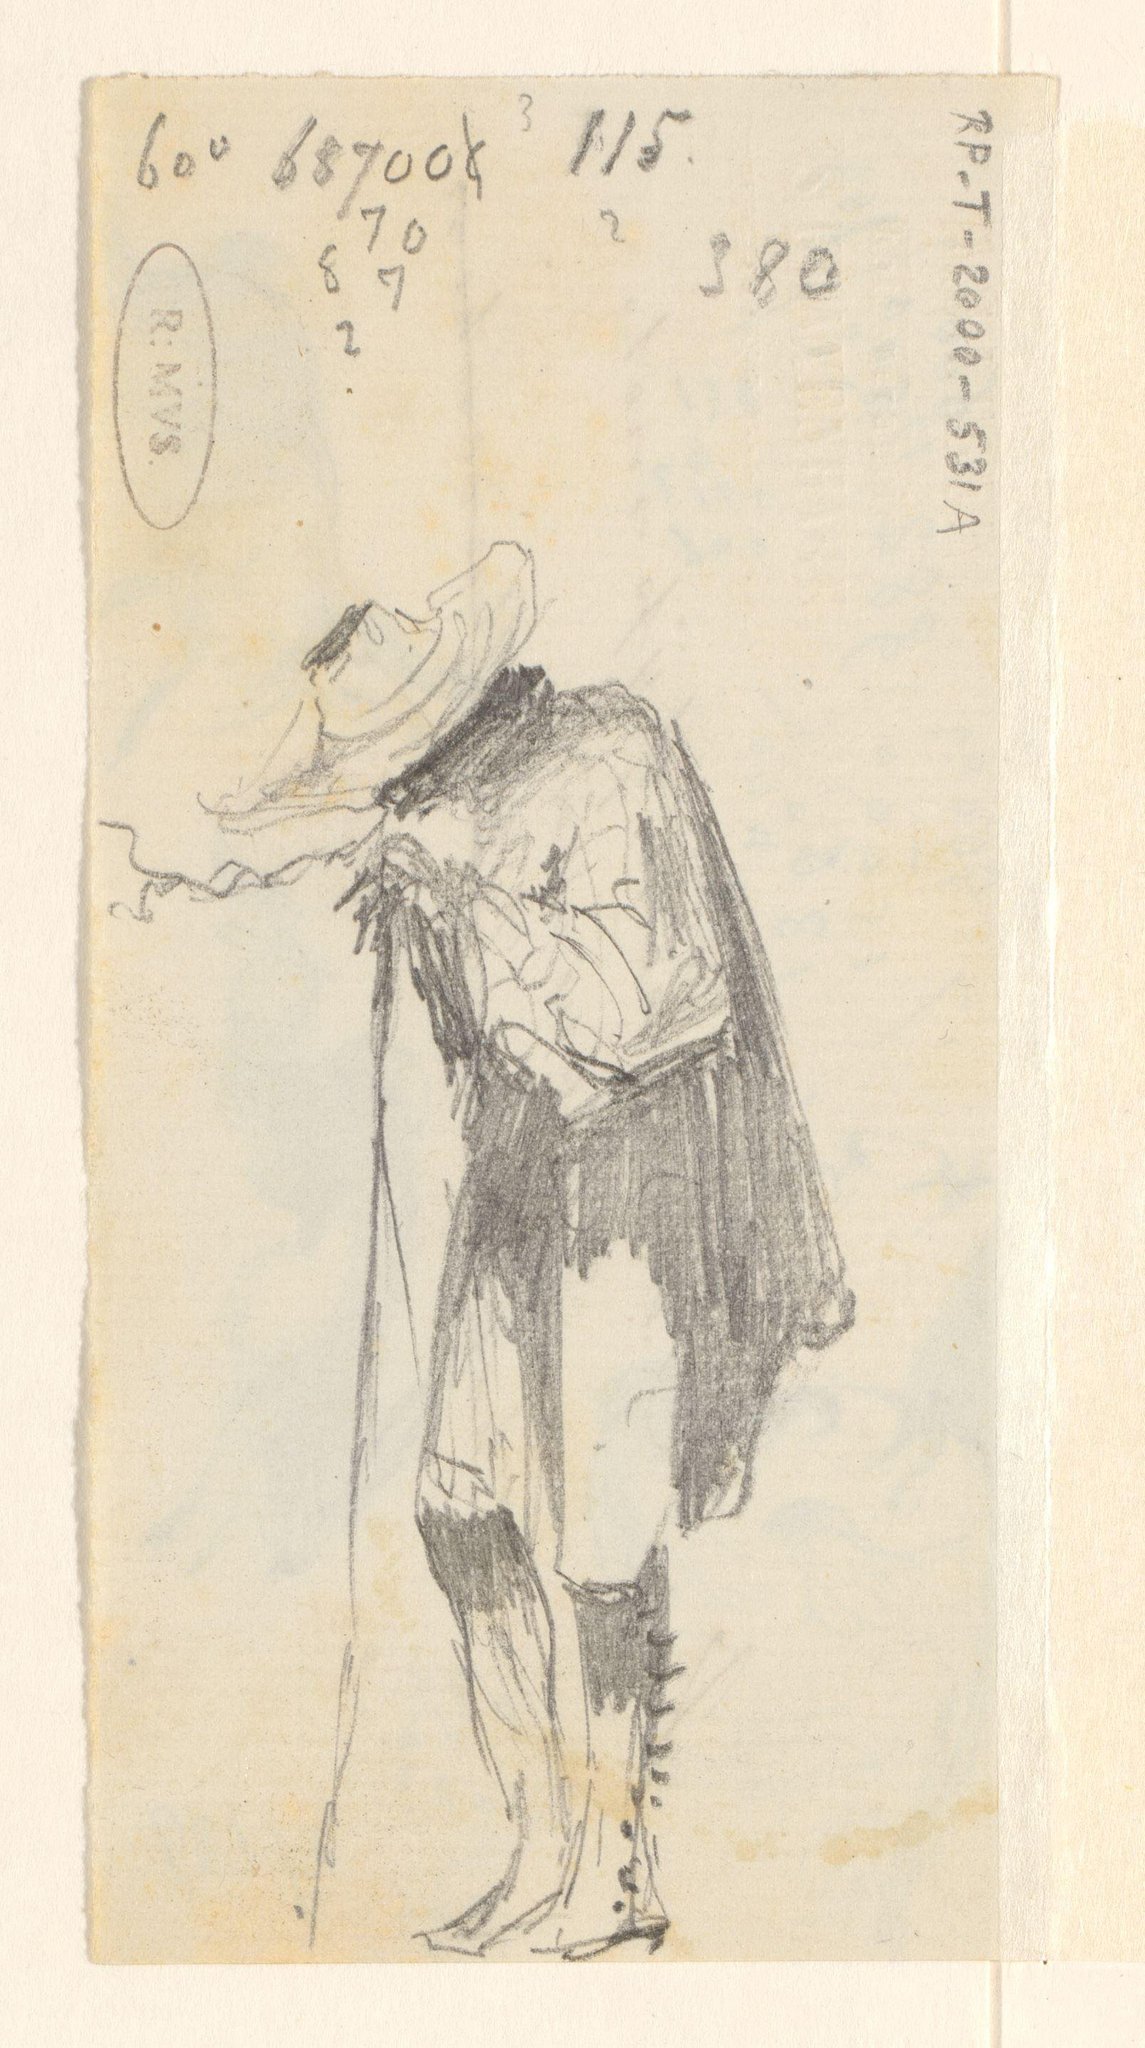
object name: drawing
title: Staande figuur met hoed en staf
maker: johannes tavenraat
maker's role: draughtsman, painter, print maker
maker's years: 1809-1881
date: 1840-1880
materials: paper, pencil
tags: standing figure, herding, herdsman, herdswoman, shepherd, shepherdess, cowherd, etc.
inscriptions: collector's mark: Lugt 2228